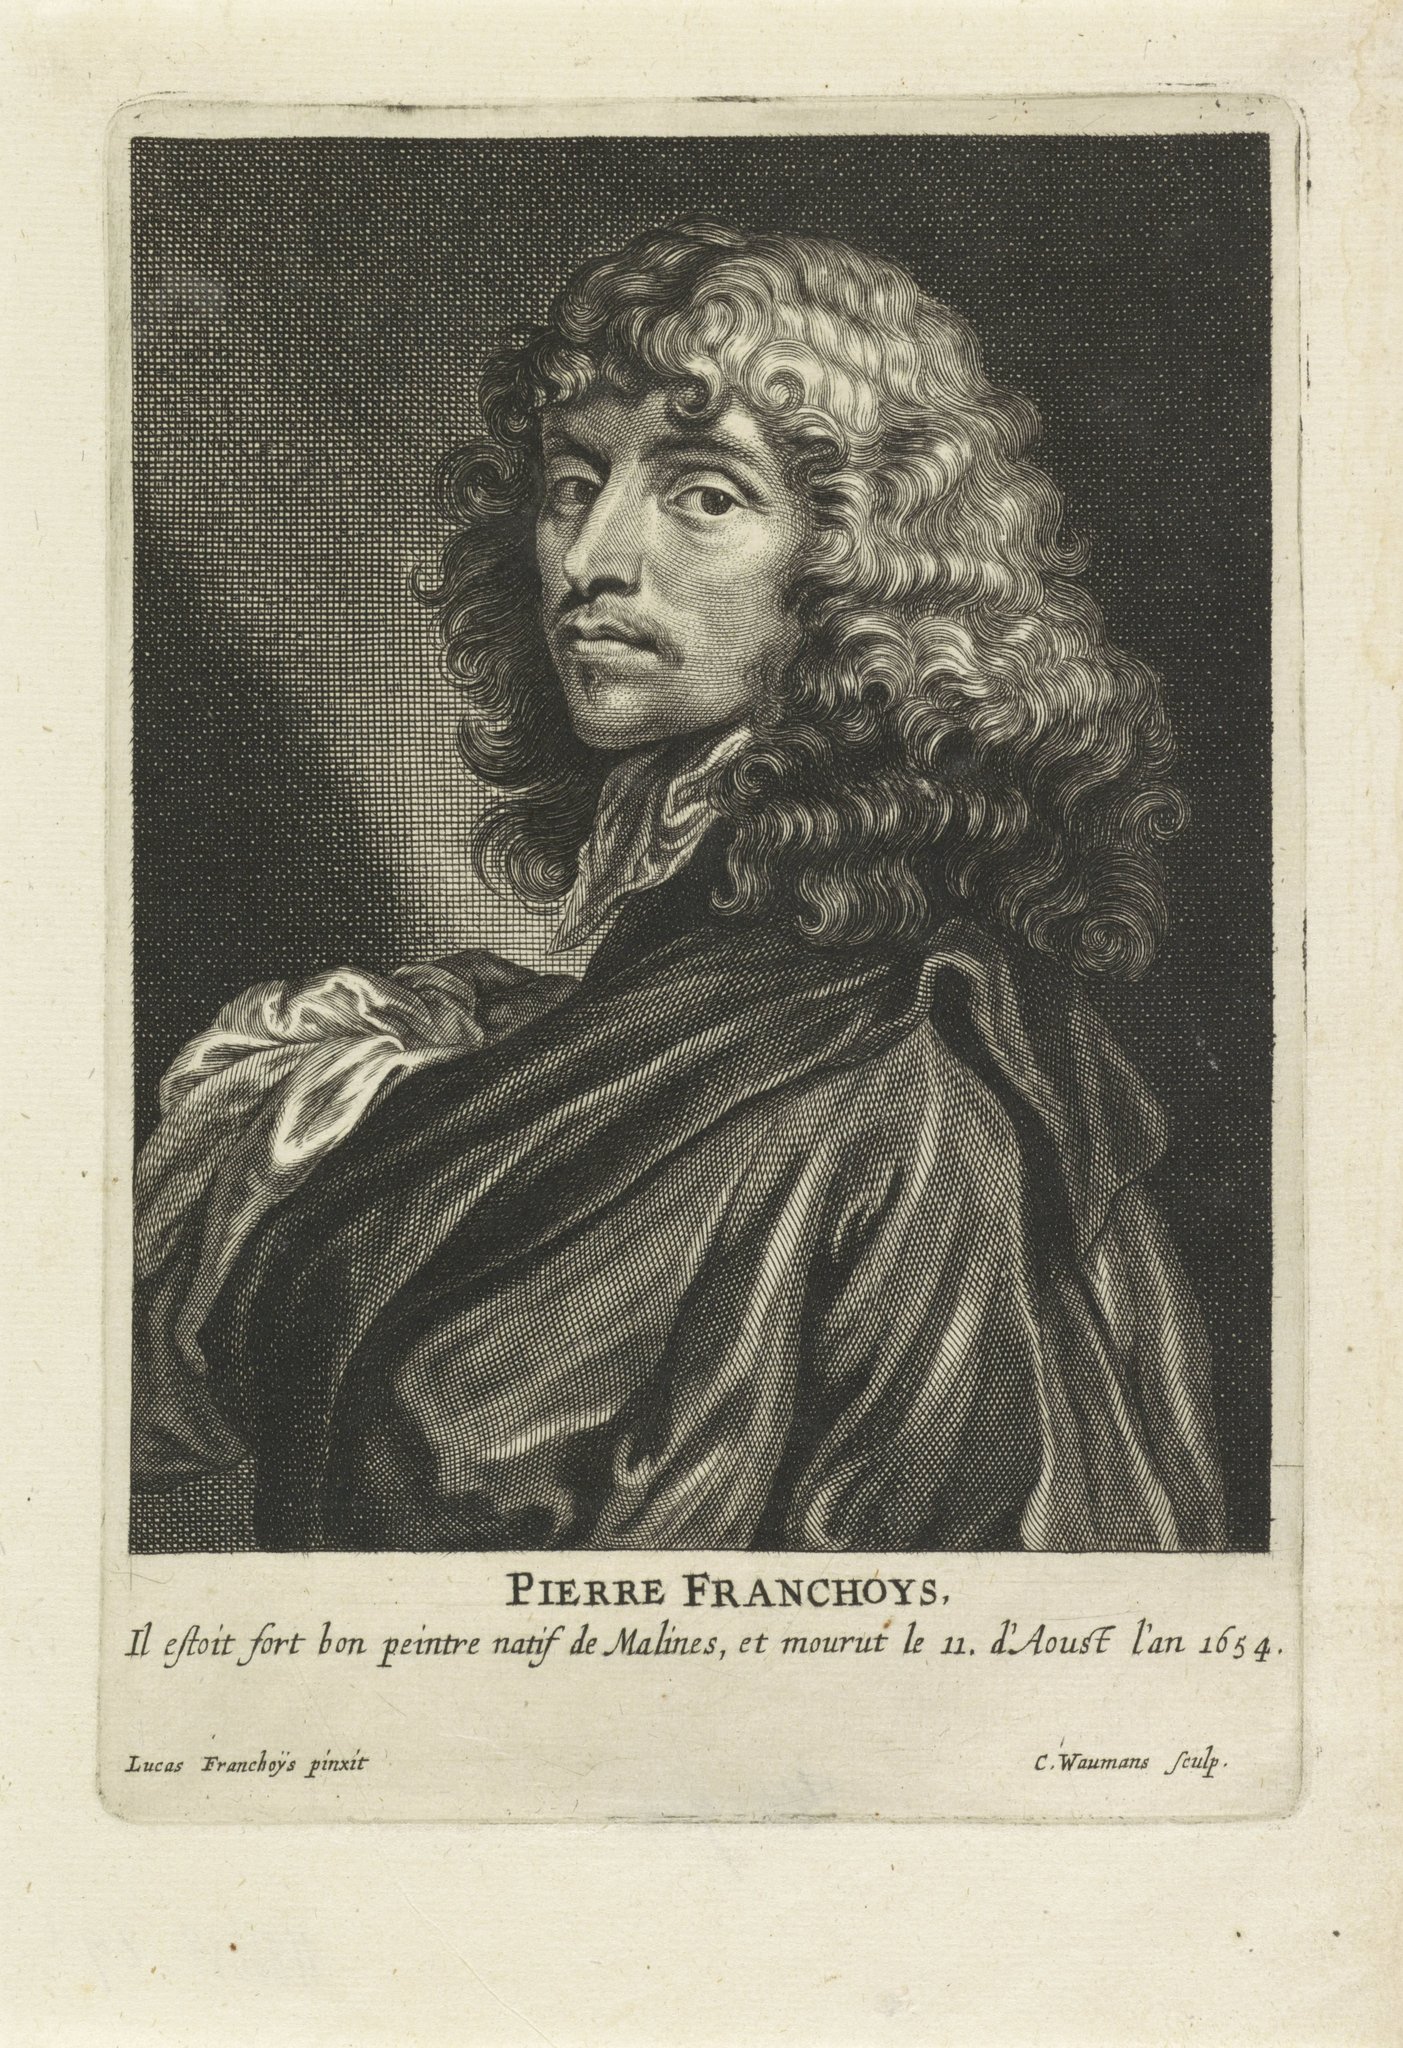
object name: print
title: Portret van de schilder Peter Franchoys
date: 1649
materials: paper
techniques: engraving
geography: antwerp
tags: mechelen, print maker, peter franchoys, portrait, self-portrait of painter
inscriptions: collector's mark: Lugt 2760, collector's mark: Lugt 2228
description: Prent gebruikt in: Image de divers hommes d'esprit sublime, qui par leur art et science devraient vivre éternellement et desquels la louange et renommée faict estonner le monde. Antwerpen: J. Meyssens, 1649.